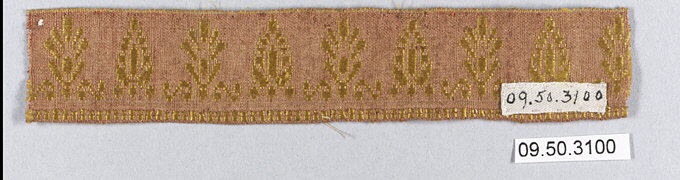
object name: gimp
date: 1701-1900